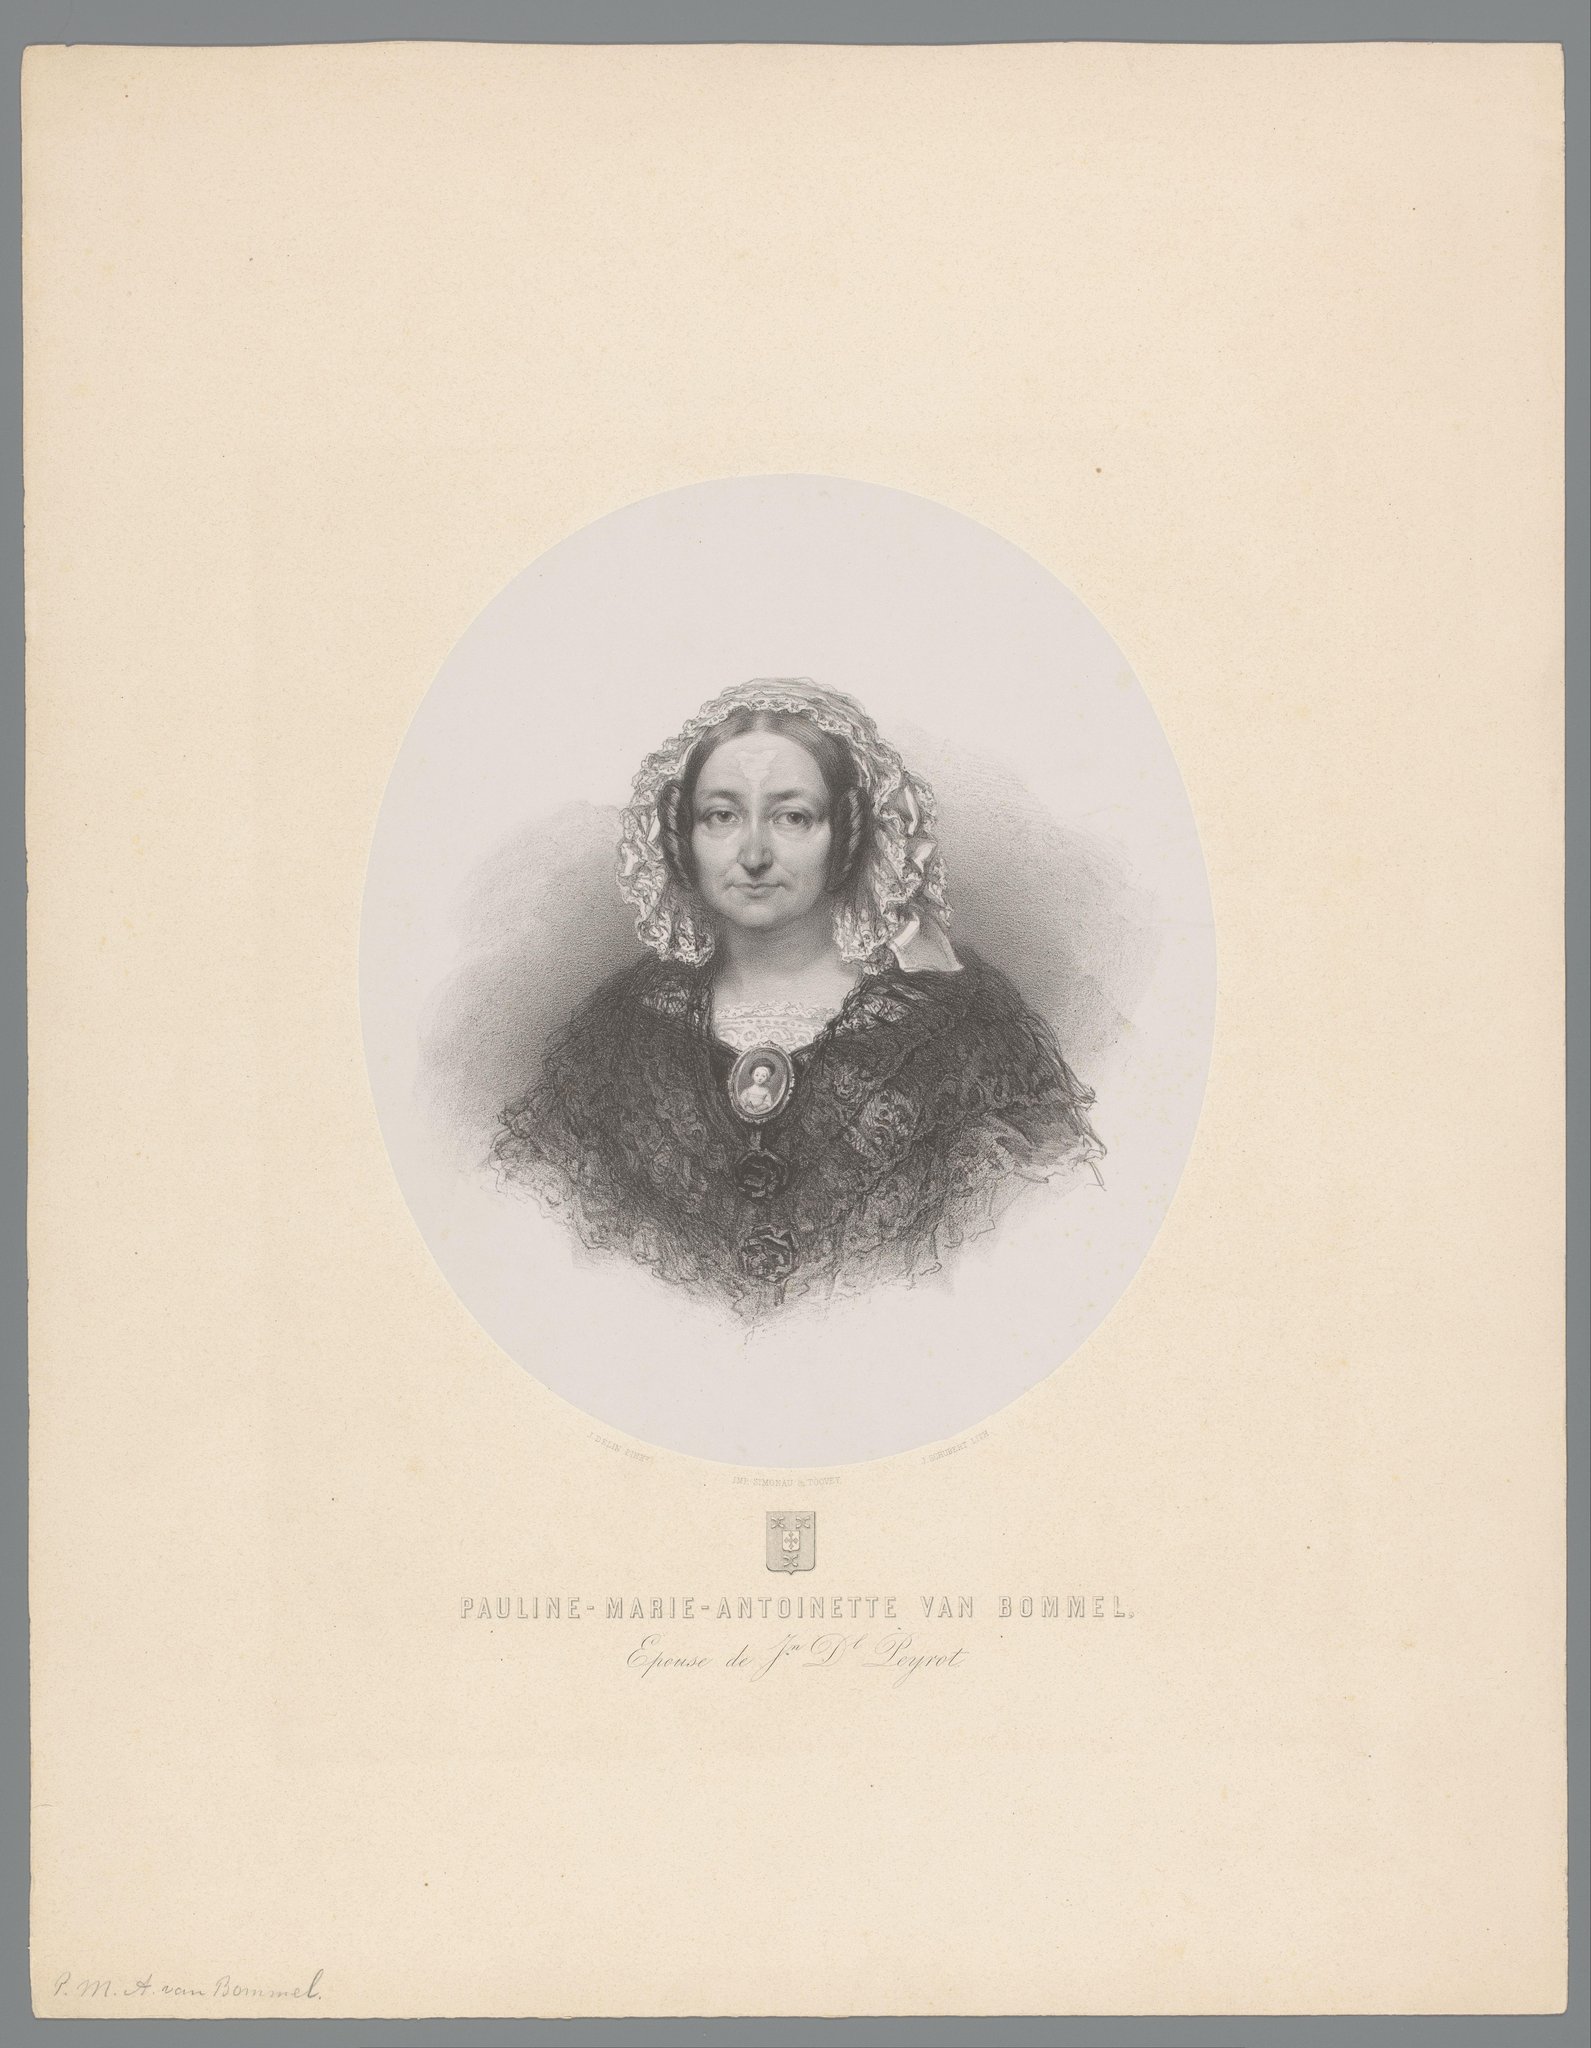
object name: print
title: Portret van Paulina Maria Antoinette van Bommel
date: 1841-1885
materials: paper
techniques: lithograph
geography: brussels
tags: leiden, antwerp, historical persons - bb - woman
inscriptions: collector's mark: Lugt 2228